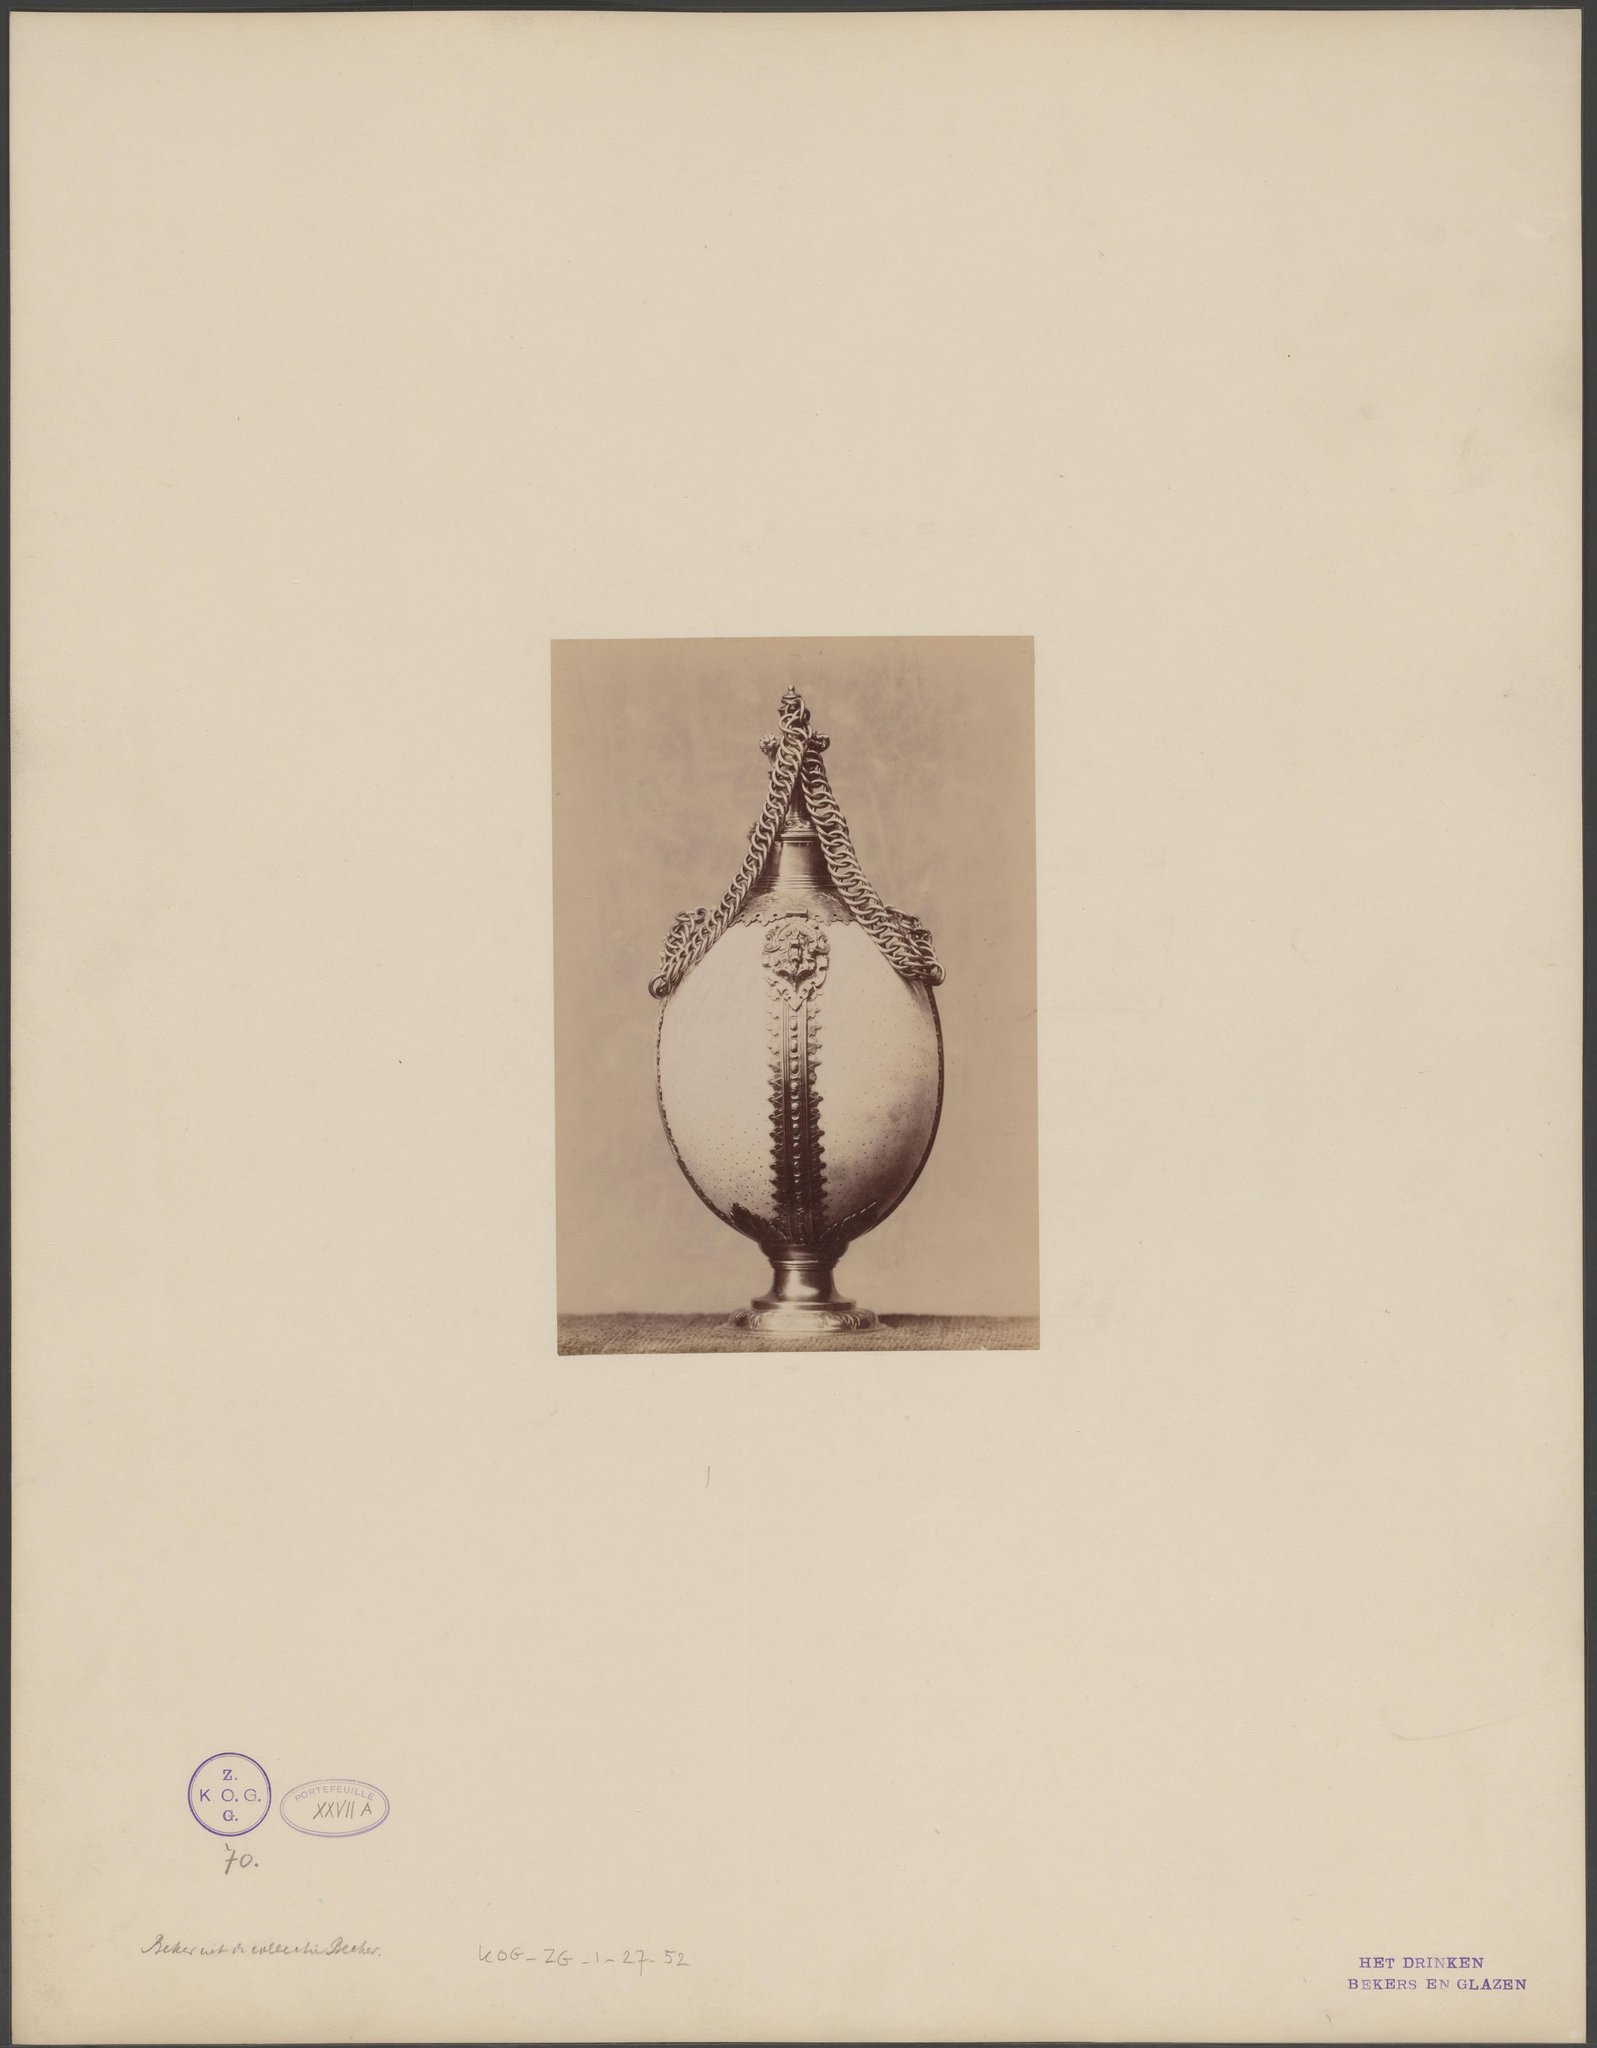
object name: photograph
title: Drinkbeker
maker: Anonymous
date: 1880-1920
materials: photographic support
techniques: albumen print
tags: drinking-vessel in unusual shape, glass, rummer, alcoholic drinks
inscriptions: collector's mark, collector's mark: Lugt 1641